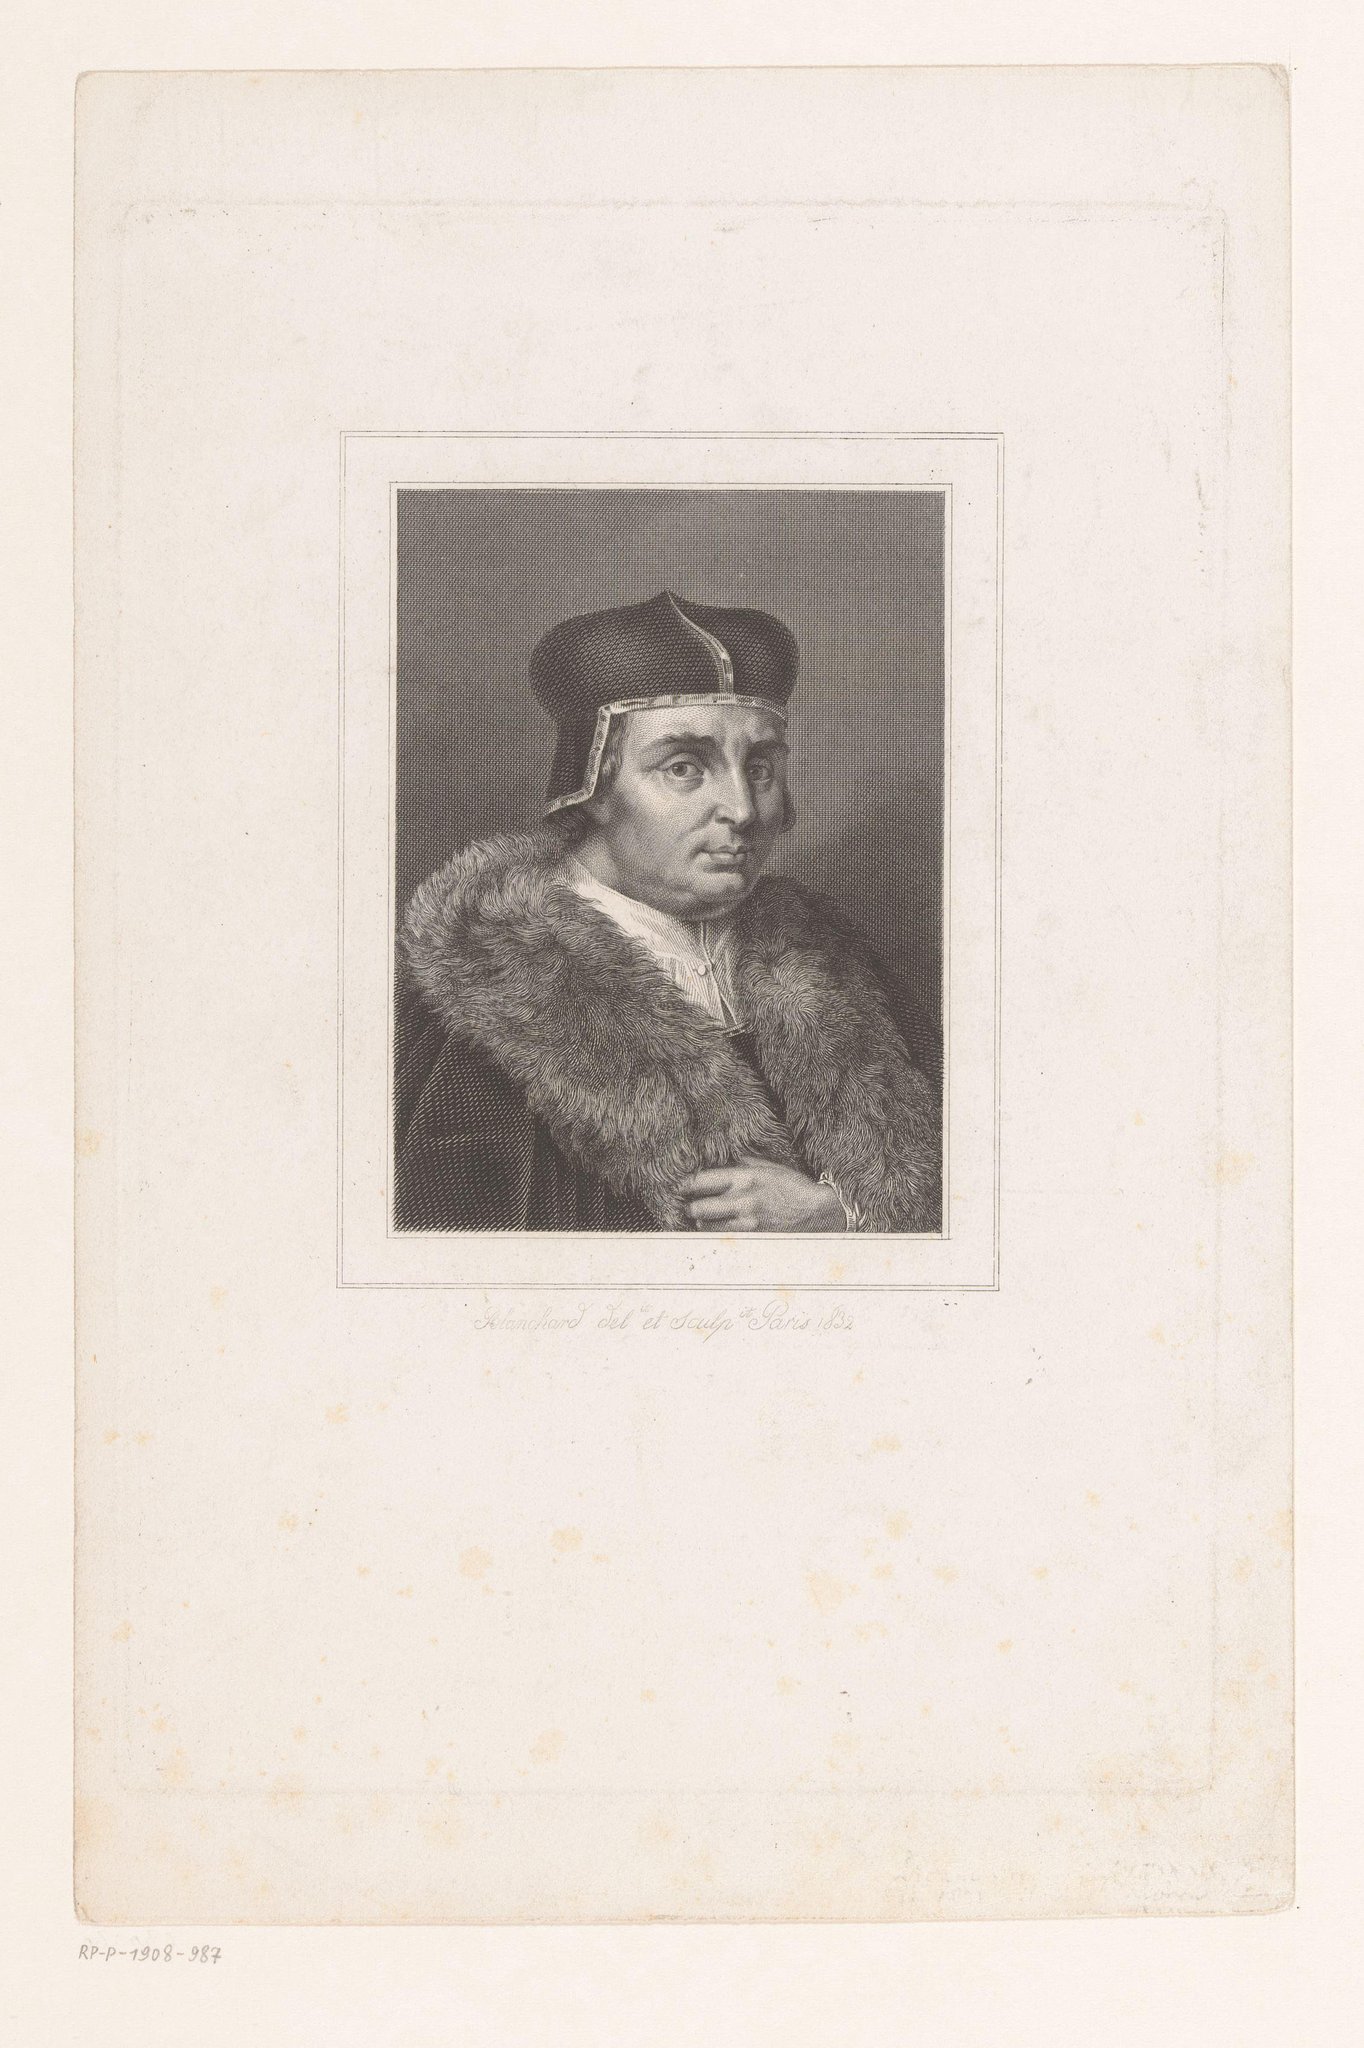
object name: print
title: Portret van een man met bontkraag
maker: auguste thomas marie blanchard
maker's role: print maker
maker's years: 1819-1898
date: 1832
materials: paper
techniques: engraving, etching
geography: paris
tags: historical persons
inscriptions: collector's mark: Lugt 2228